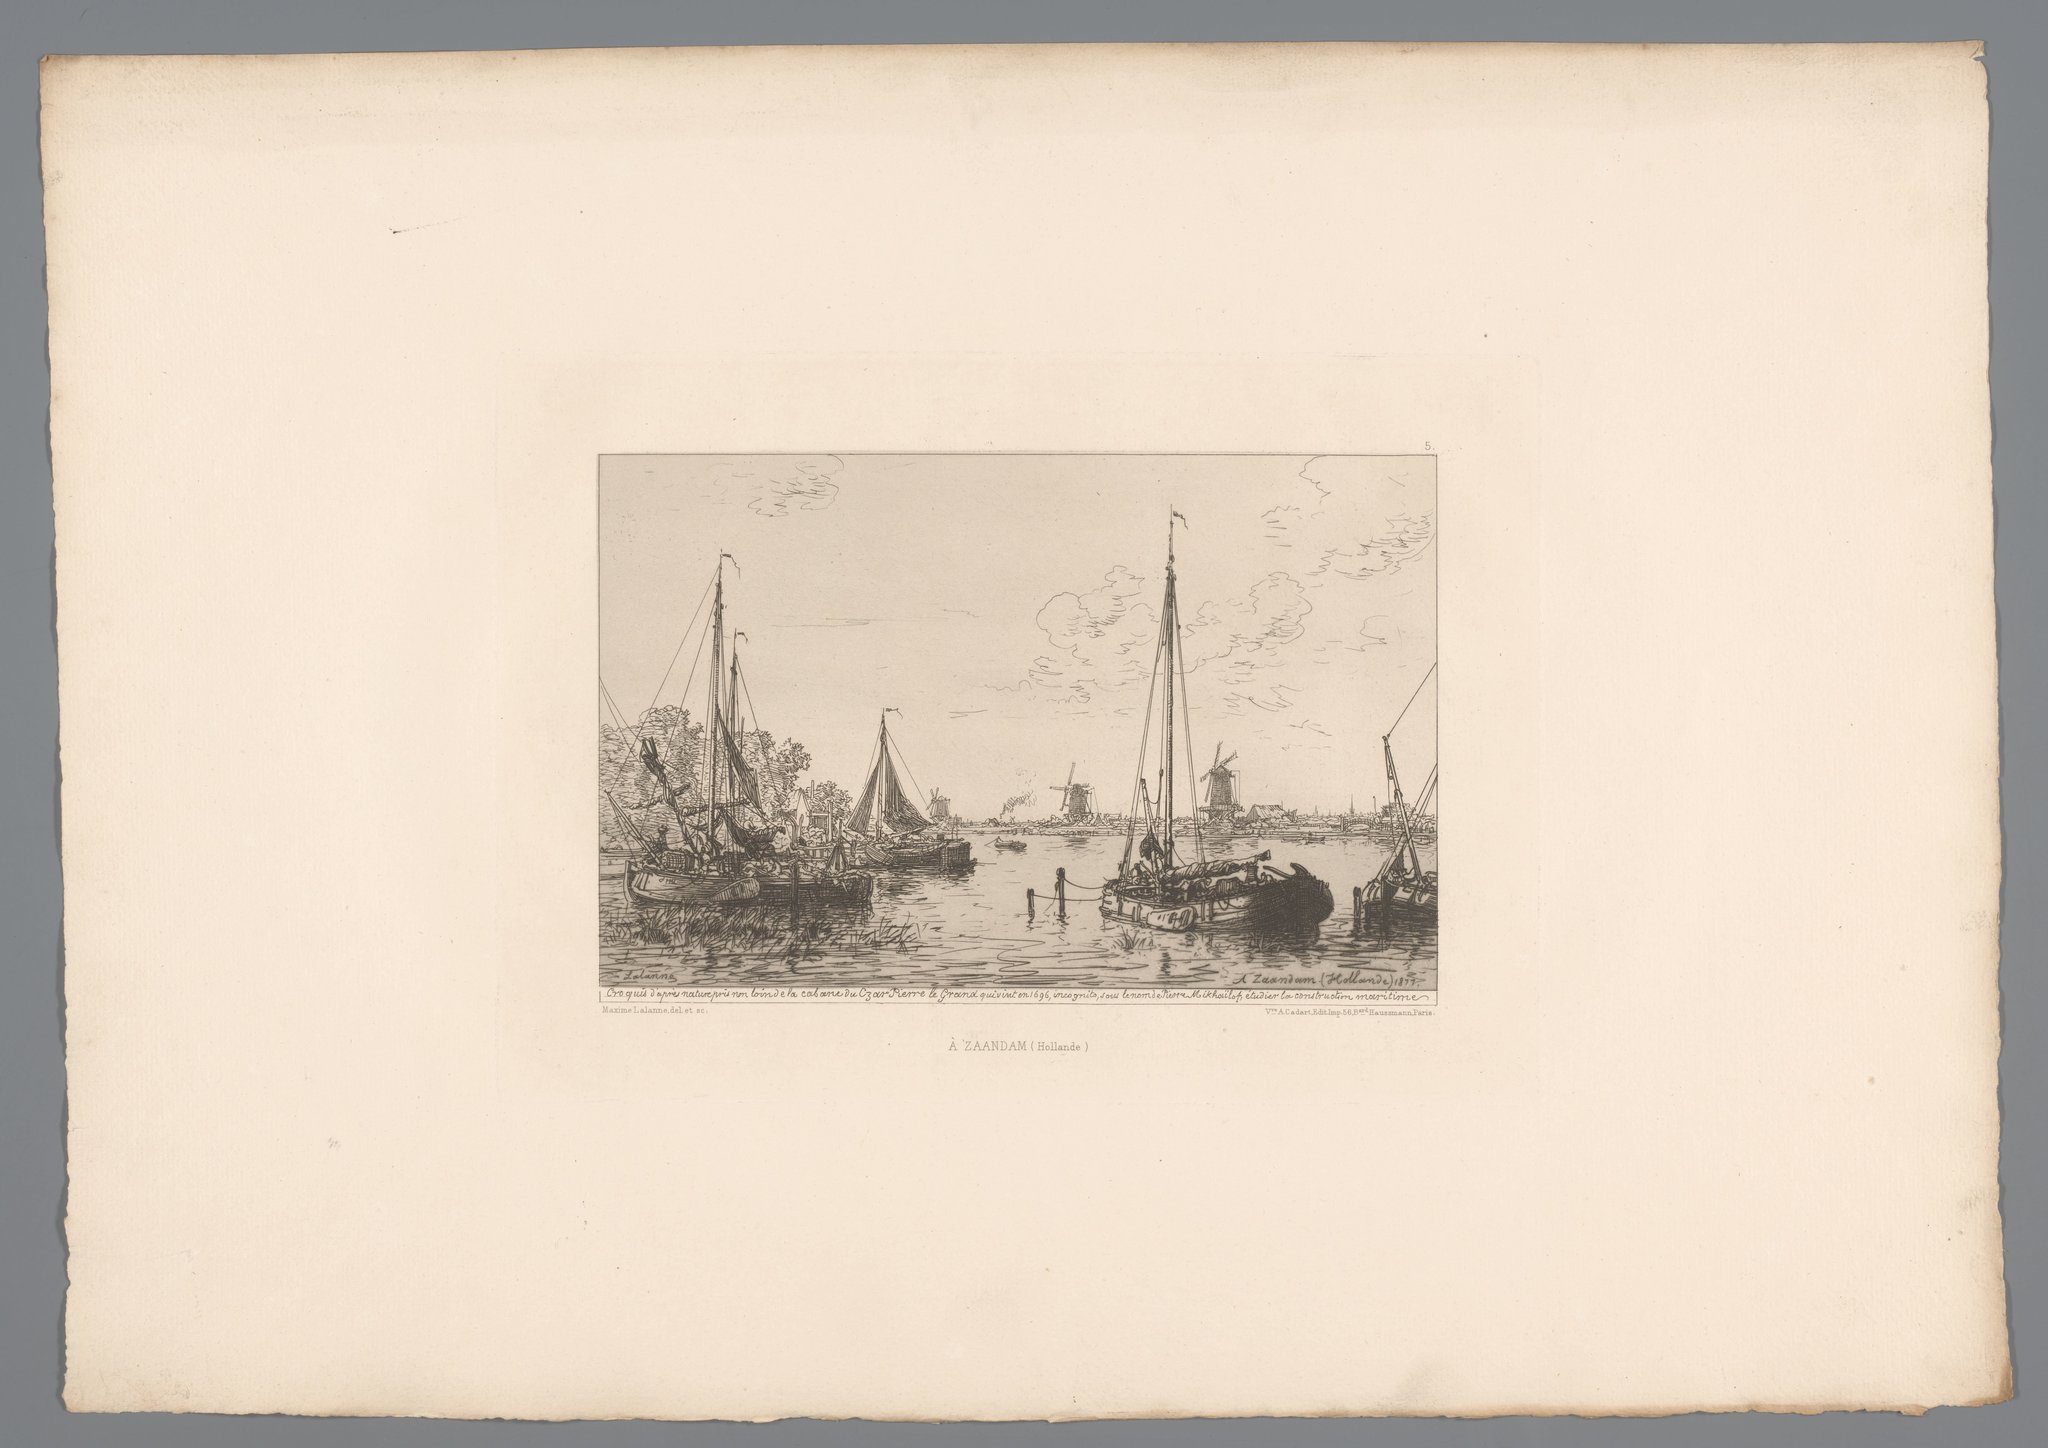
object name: print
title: Gezicht op Zaandam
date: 1878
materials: paper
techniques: drypoint, etching, intaglio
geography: paris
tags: harbour, water course, windmill in landscape, windmill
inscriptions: collector's mark: ‘AFE v S’, watermark, collector's mark: Lugt 2228, collector's mark: Lugt 2760